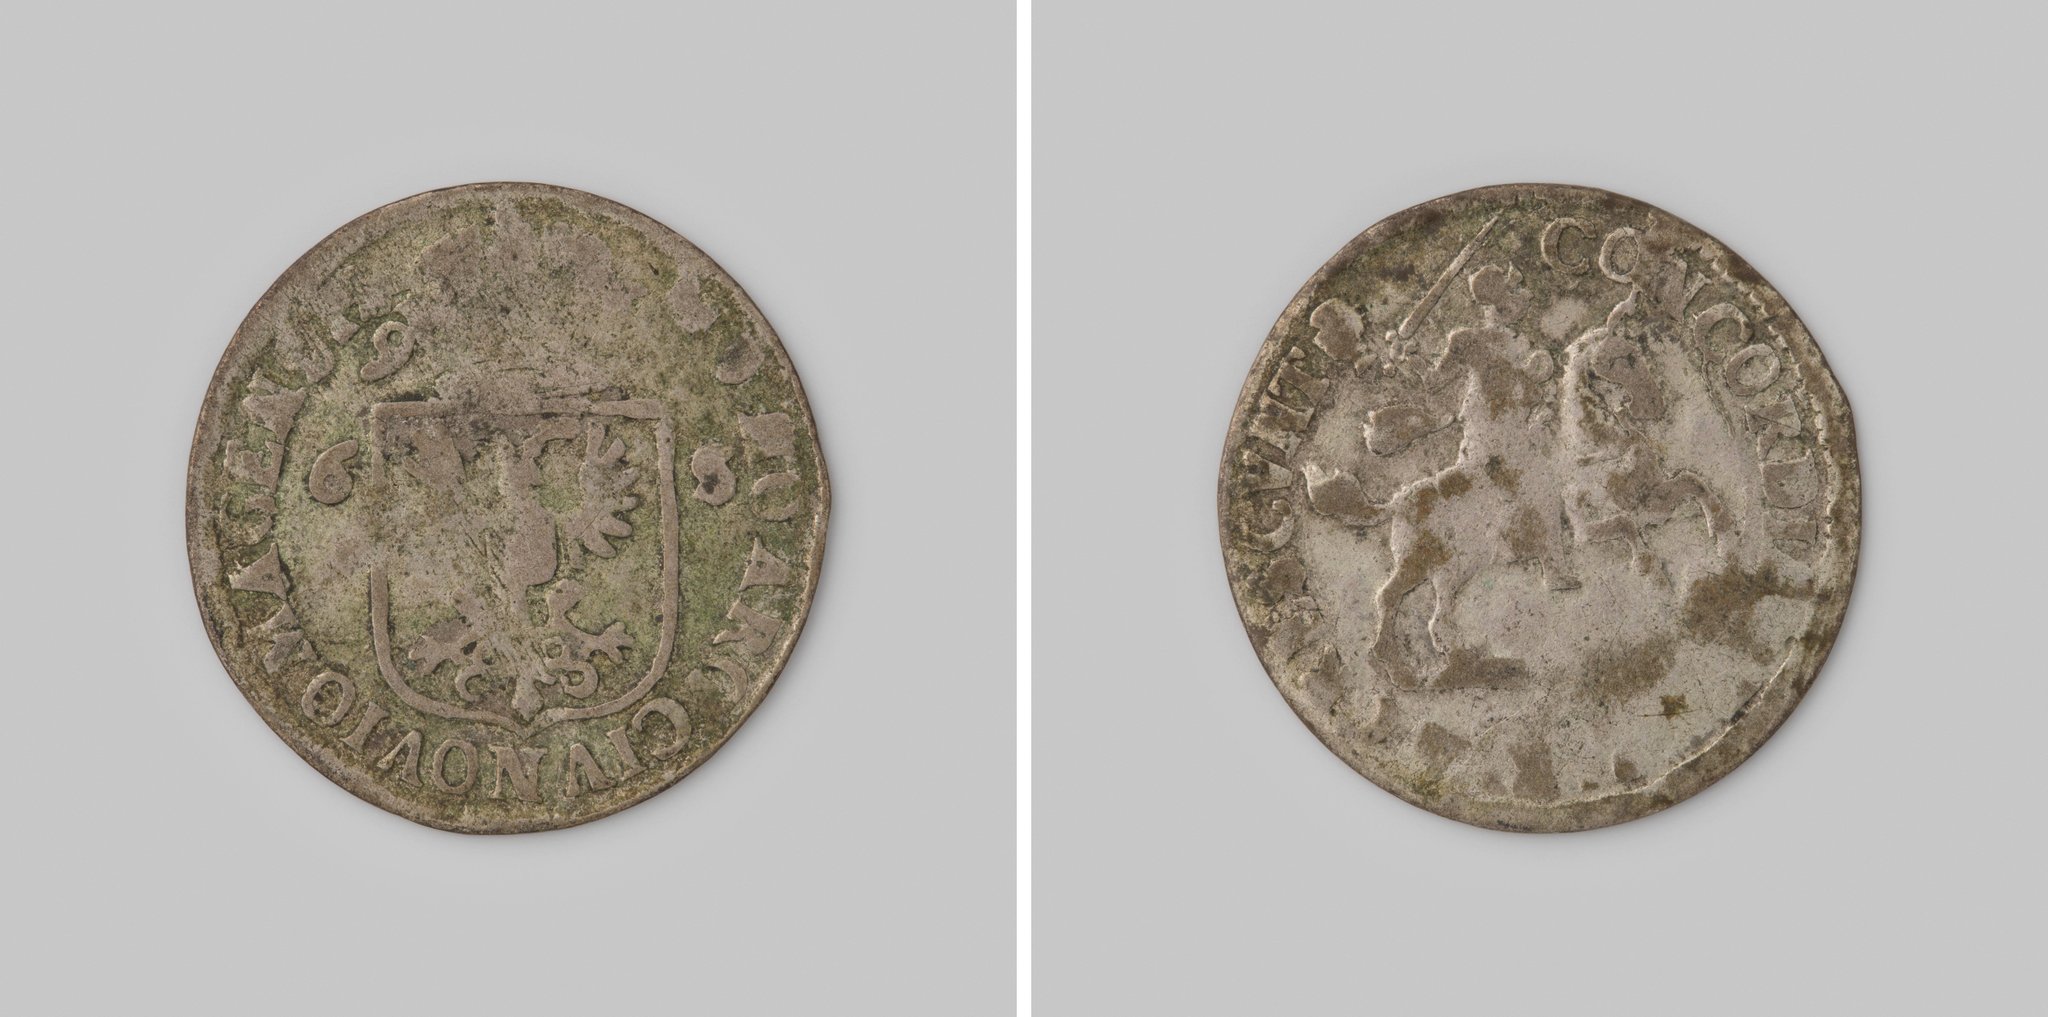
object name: coin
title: Nijmegen, ruiterschelling, 1690/1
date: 1690-1691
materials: silver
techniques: striking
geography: nijmegen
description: Zilveren munt. Voorzijde: tussen waarde-aanduiding 6 S gekroond wapenschild van Nijmegen. Naast de kroon tweecijferig niet goed leesbaar jaartal. Keerzijde: ridder te paard naar rechts rijdend.